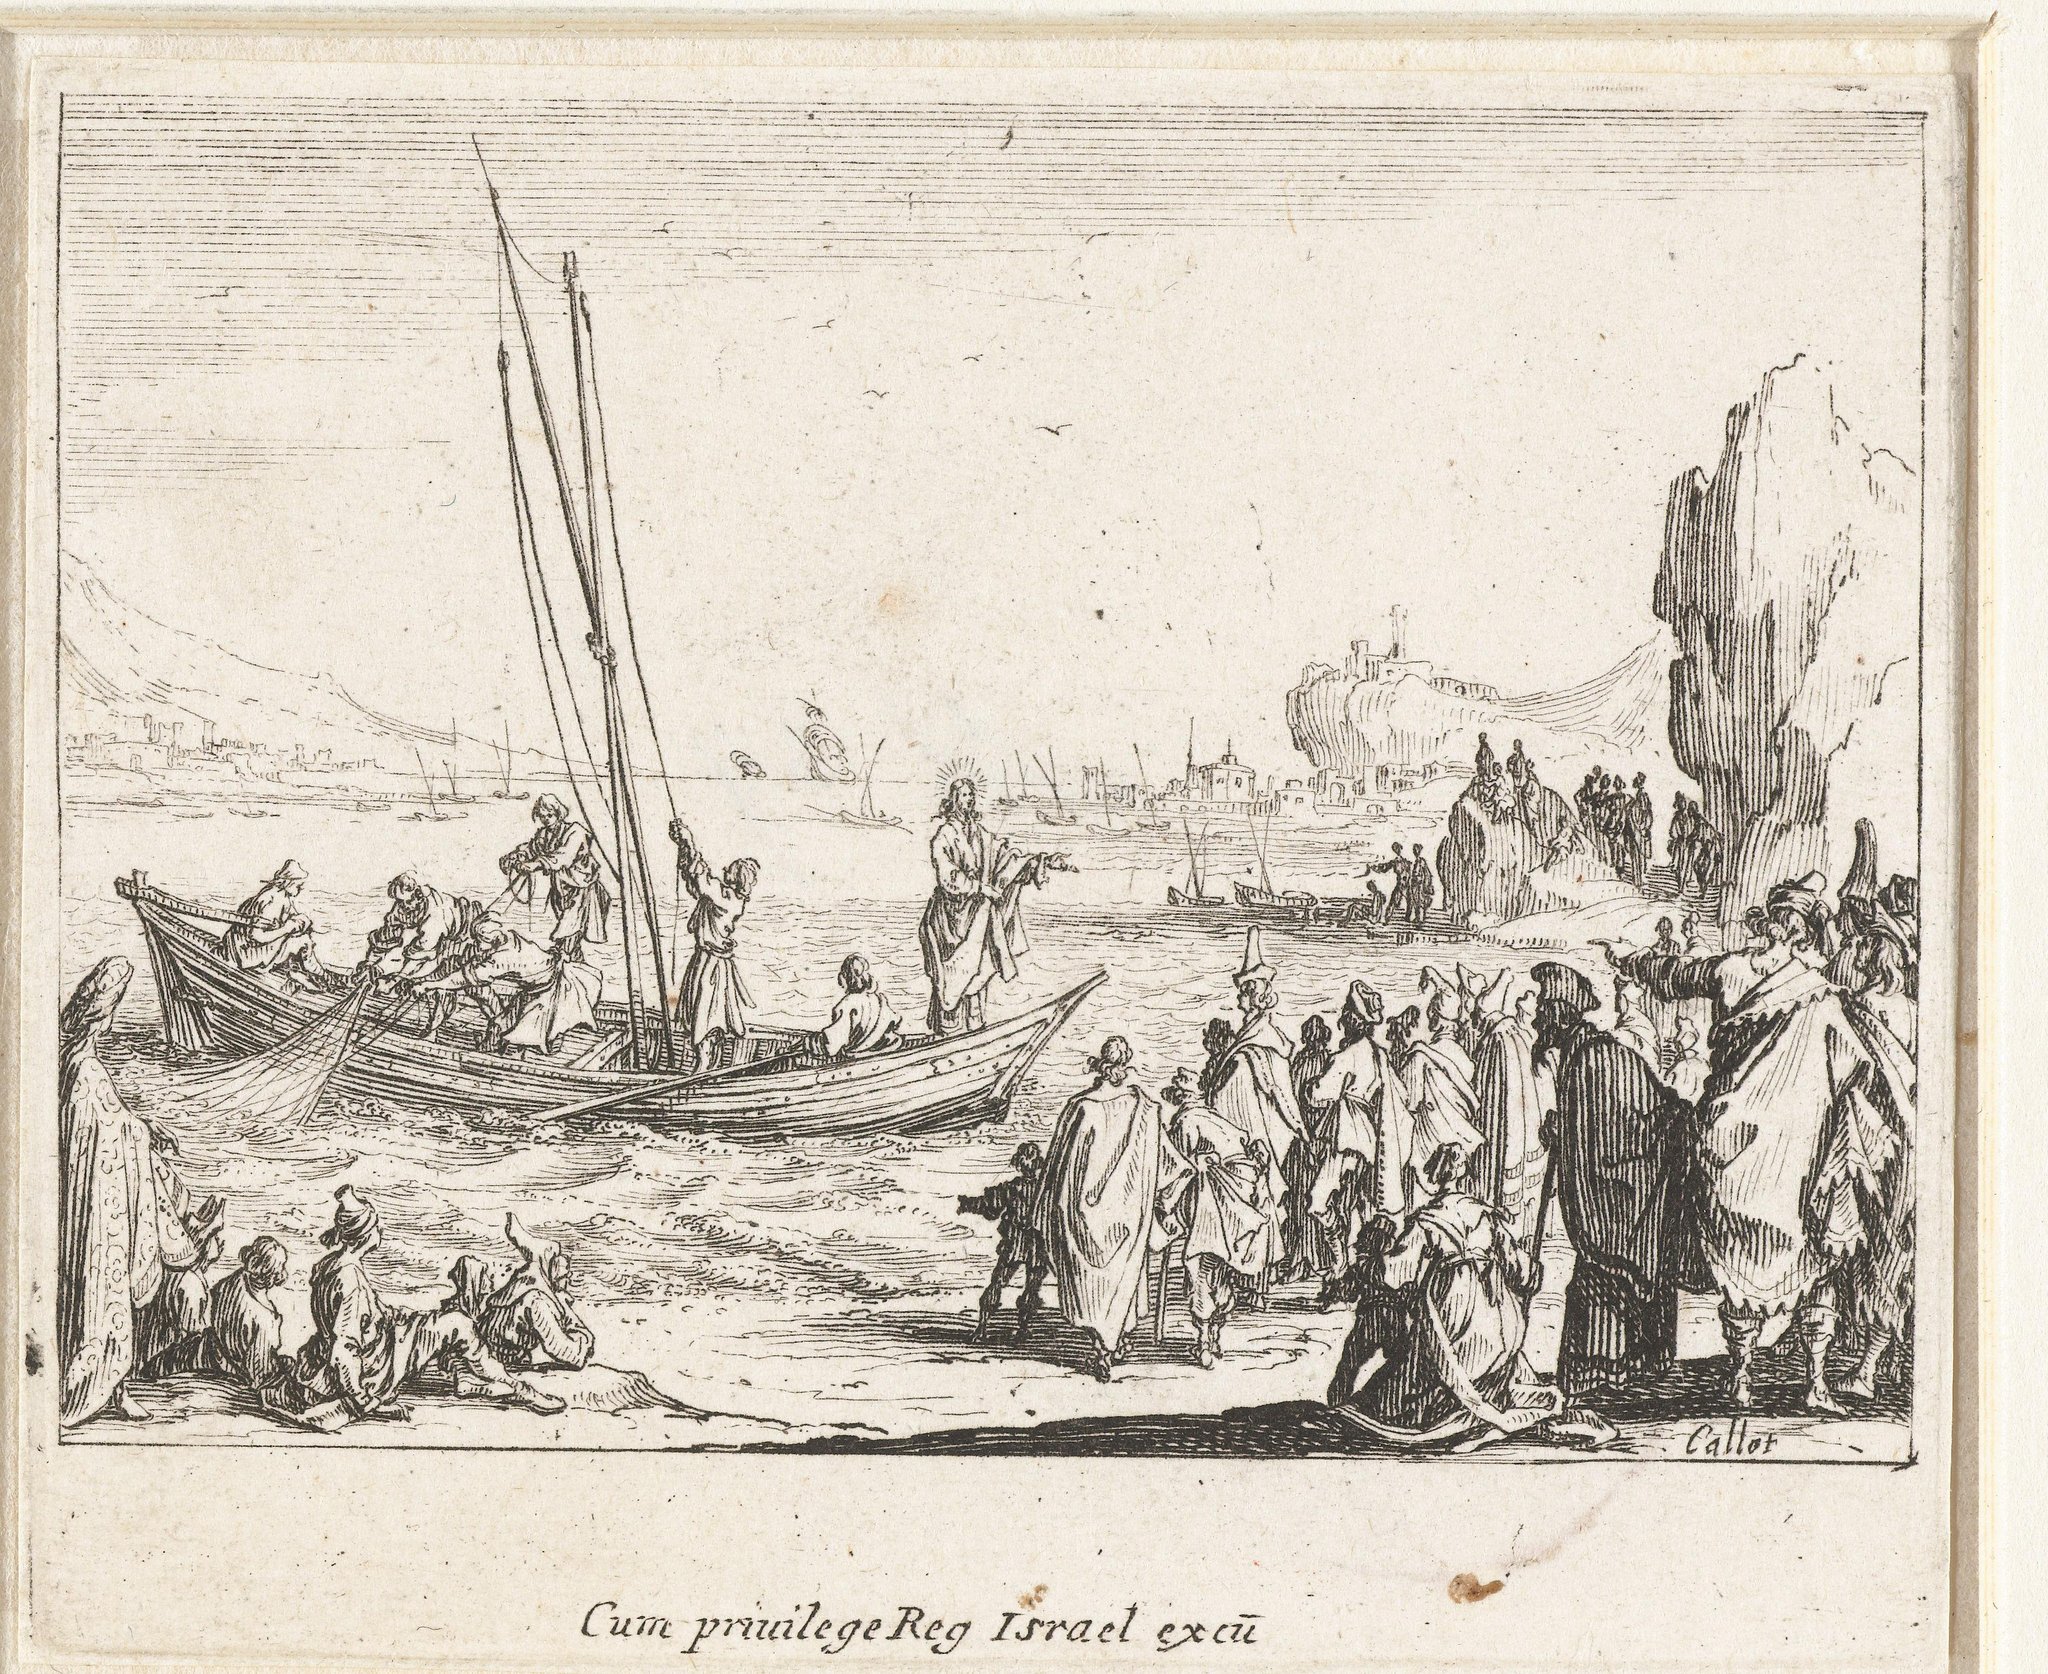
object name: print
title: Scènes uit het Nieuwe Testament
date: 1635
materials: paper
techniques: etching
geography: paris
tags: the miraculous draught of fishes (before the resurrection) on the lake of gennesaret (sea of galilee); james and john helping to bring in the nets (luke 5:1-11), christ preaching from a boat, christ in peter's boat preaching to the people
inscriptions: collector's mark: Lugt 240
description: Christus spreekt vanuit een boot een menigte mensen toe die op het strand staat. Achter hem halen drie mannen visnetten binnen. Deze prent is onderdeel van een reeks van tien prenten met voorstellingen uit het Nieuwe Testament, waaraan na Callots dood een titelprent is toegevoegd.